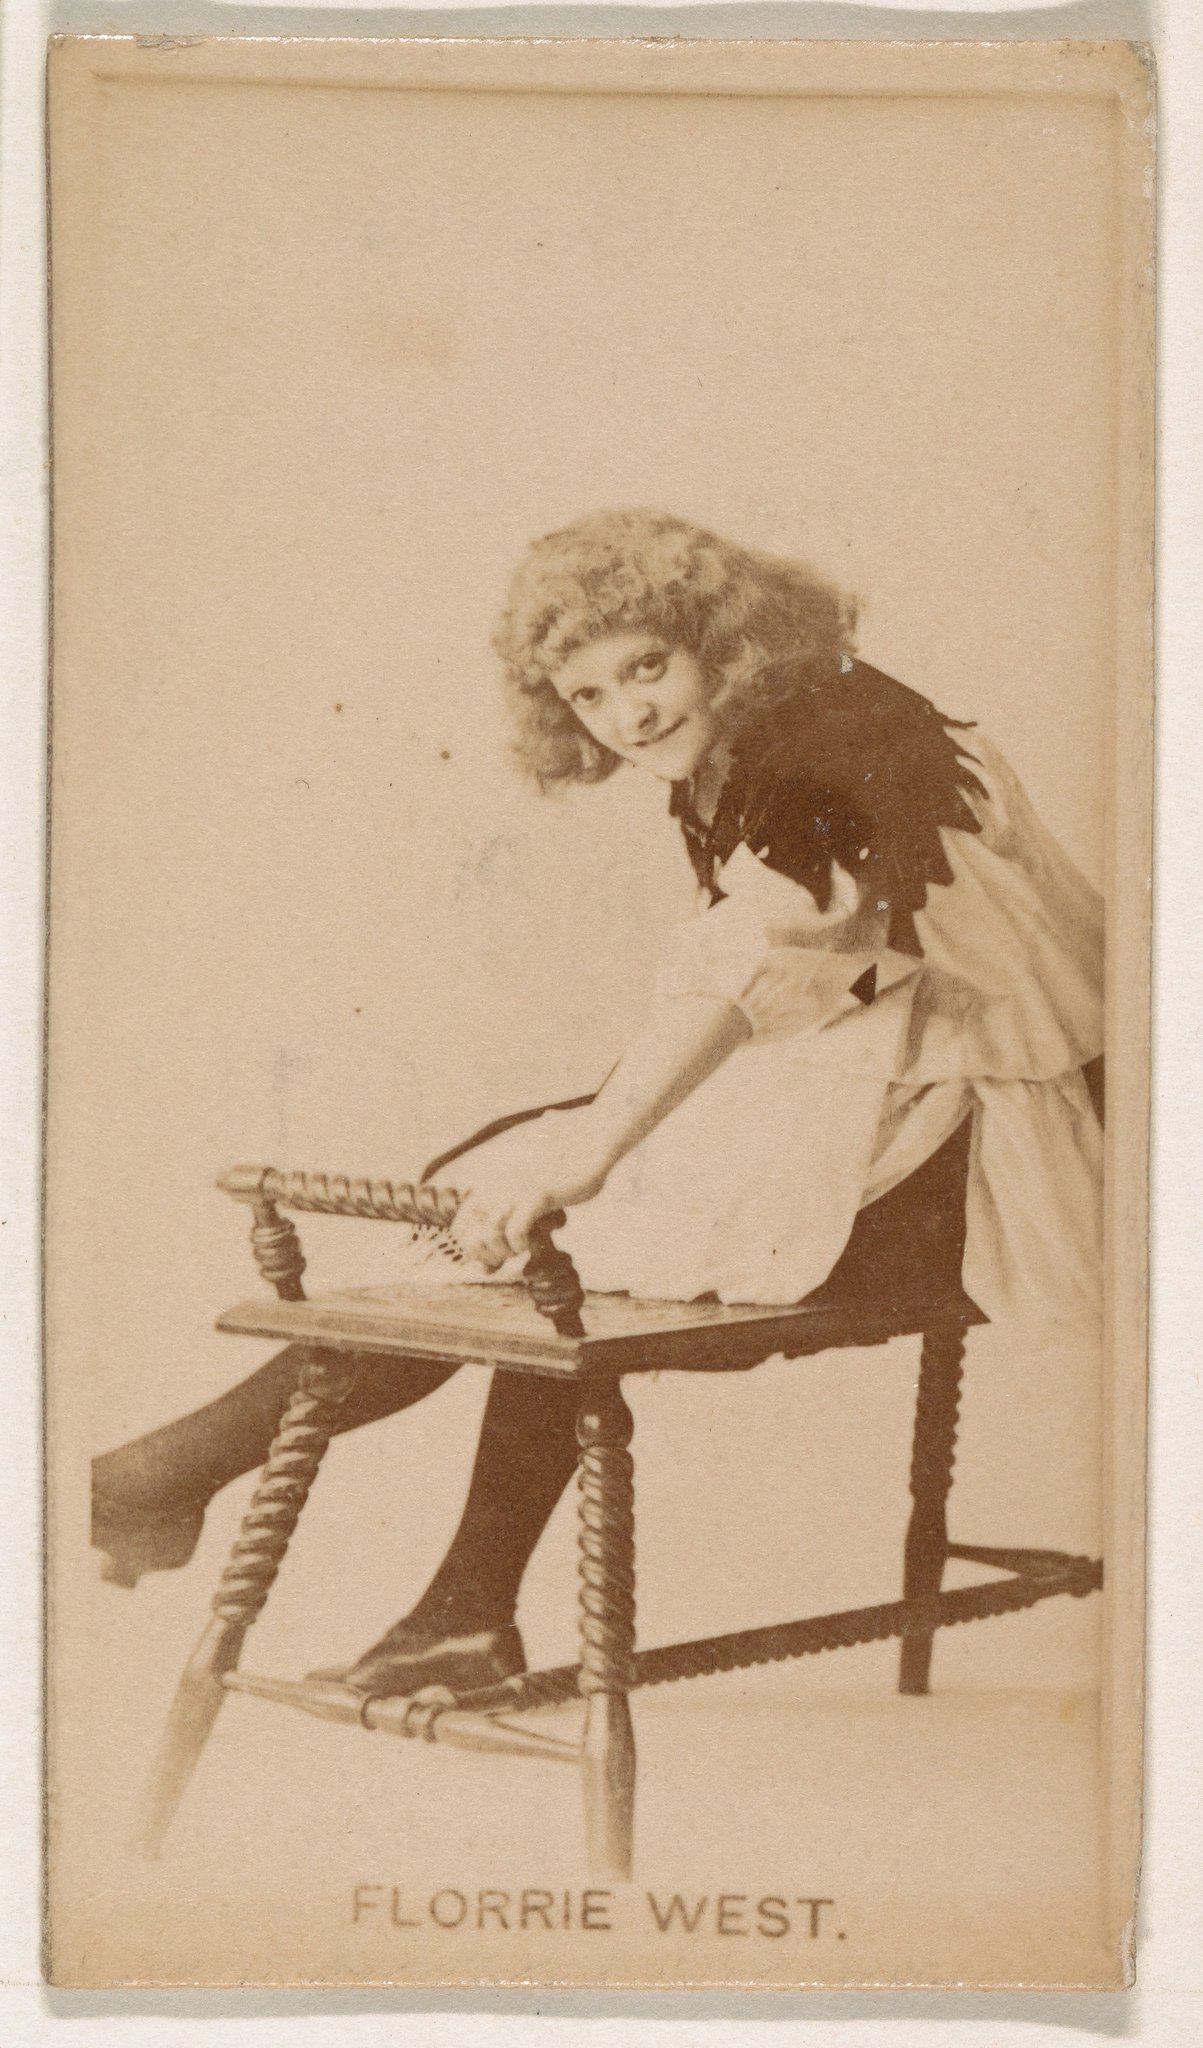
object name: photograph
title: Florrie West, from the Actresses series (N245) issued by Kinney Brothers to promote Sweet Caporal Cigarettes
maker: kinney brothers tobacco company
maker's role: publisher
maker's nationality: american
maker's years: 1869-2011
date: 1890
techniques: albumen silver print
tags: portraits,women,actresses